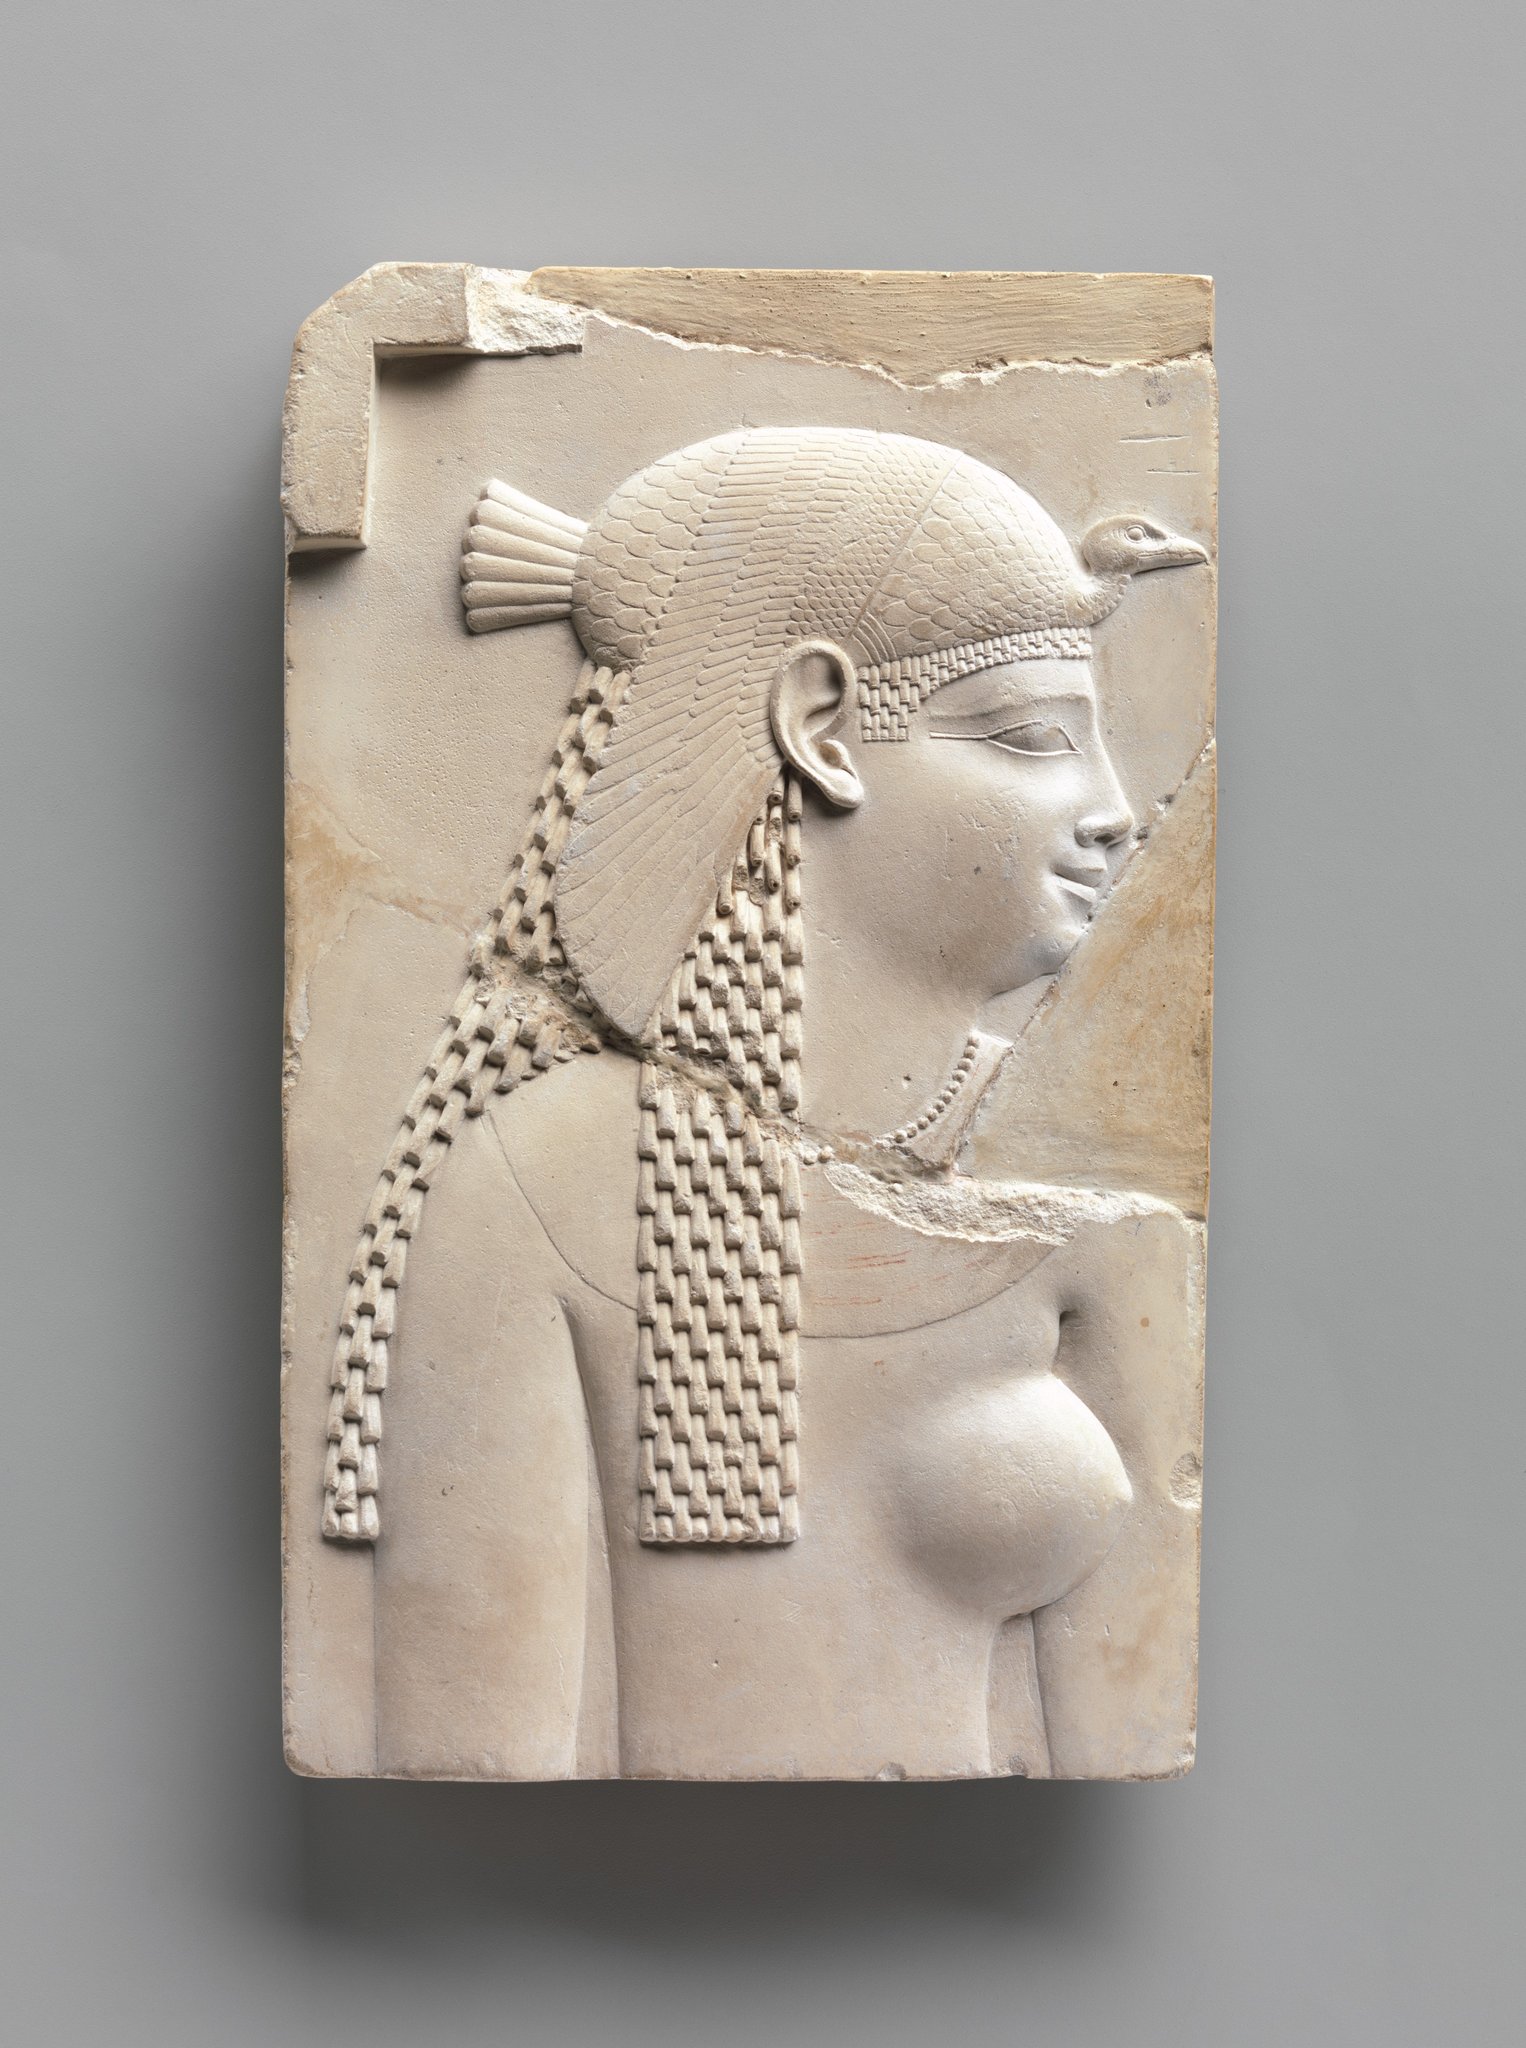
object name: sculptor's modeland or votive, goddess or queen, king on other side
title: Plaque Depicting a Goddess or Queen, and on Opposite Side a King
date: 400-200 BCE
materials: limestone, paint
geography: egypt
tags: kings,queens,goddess